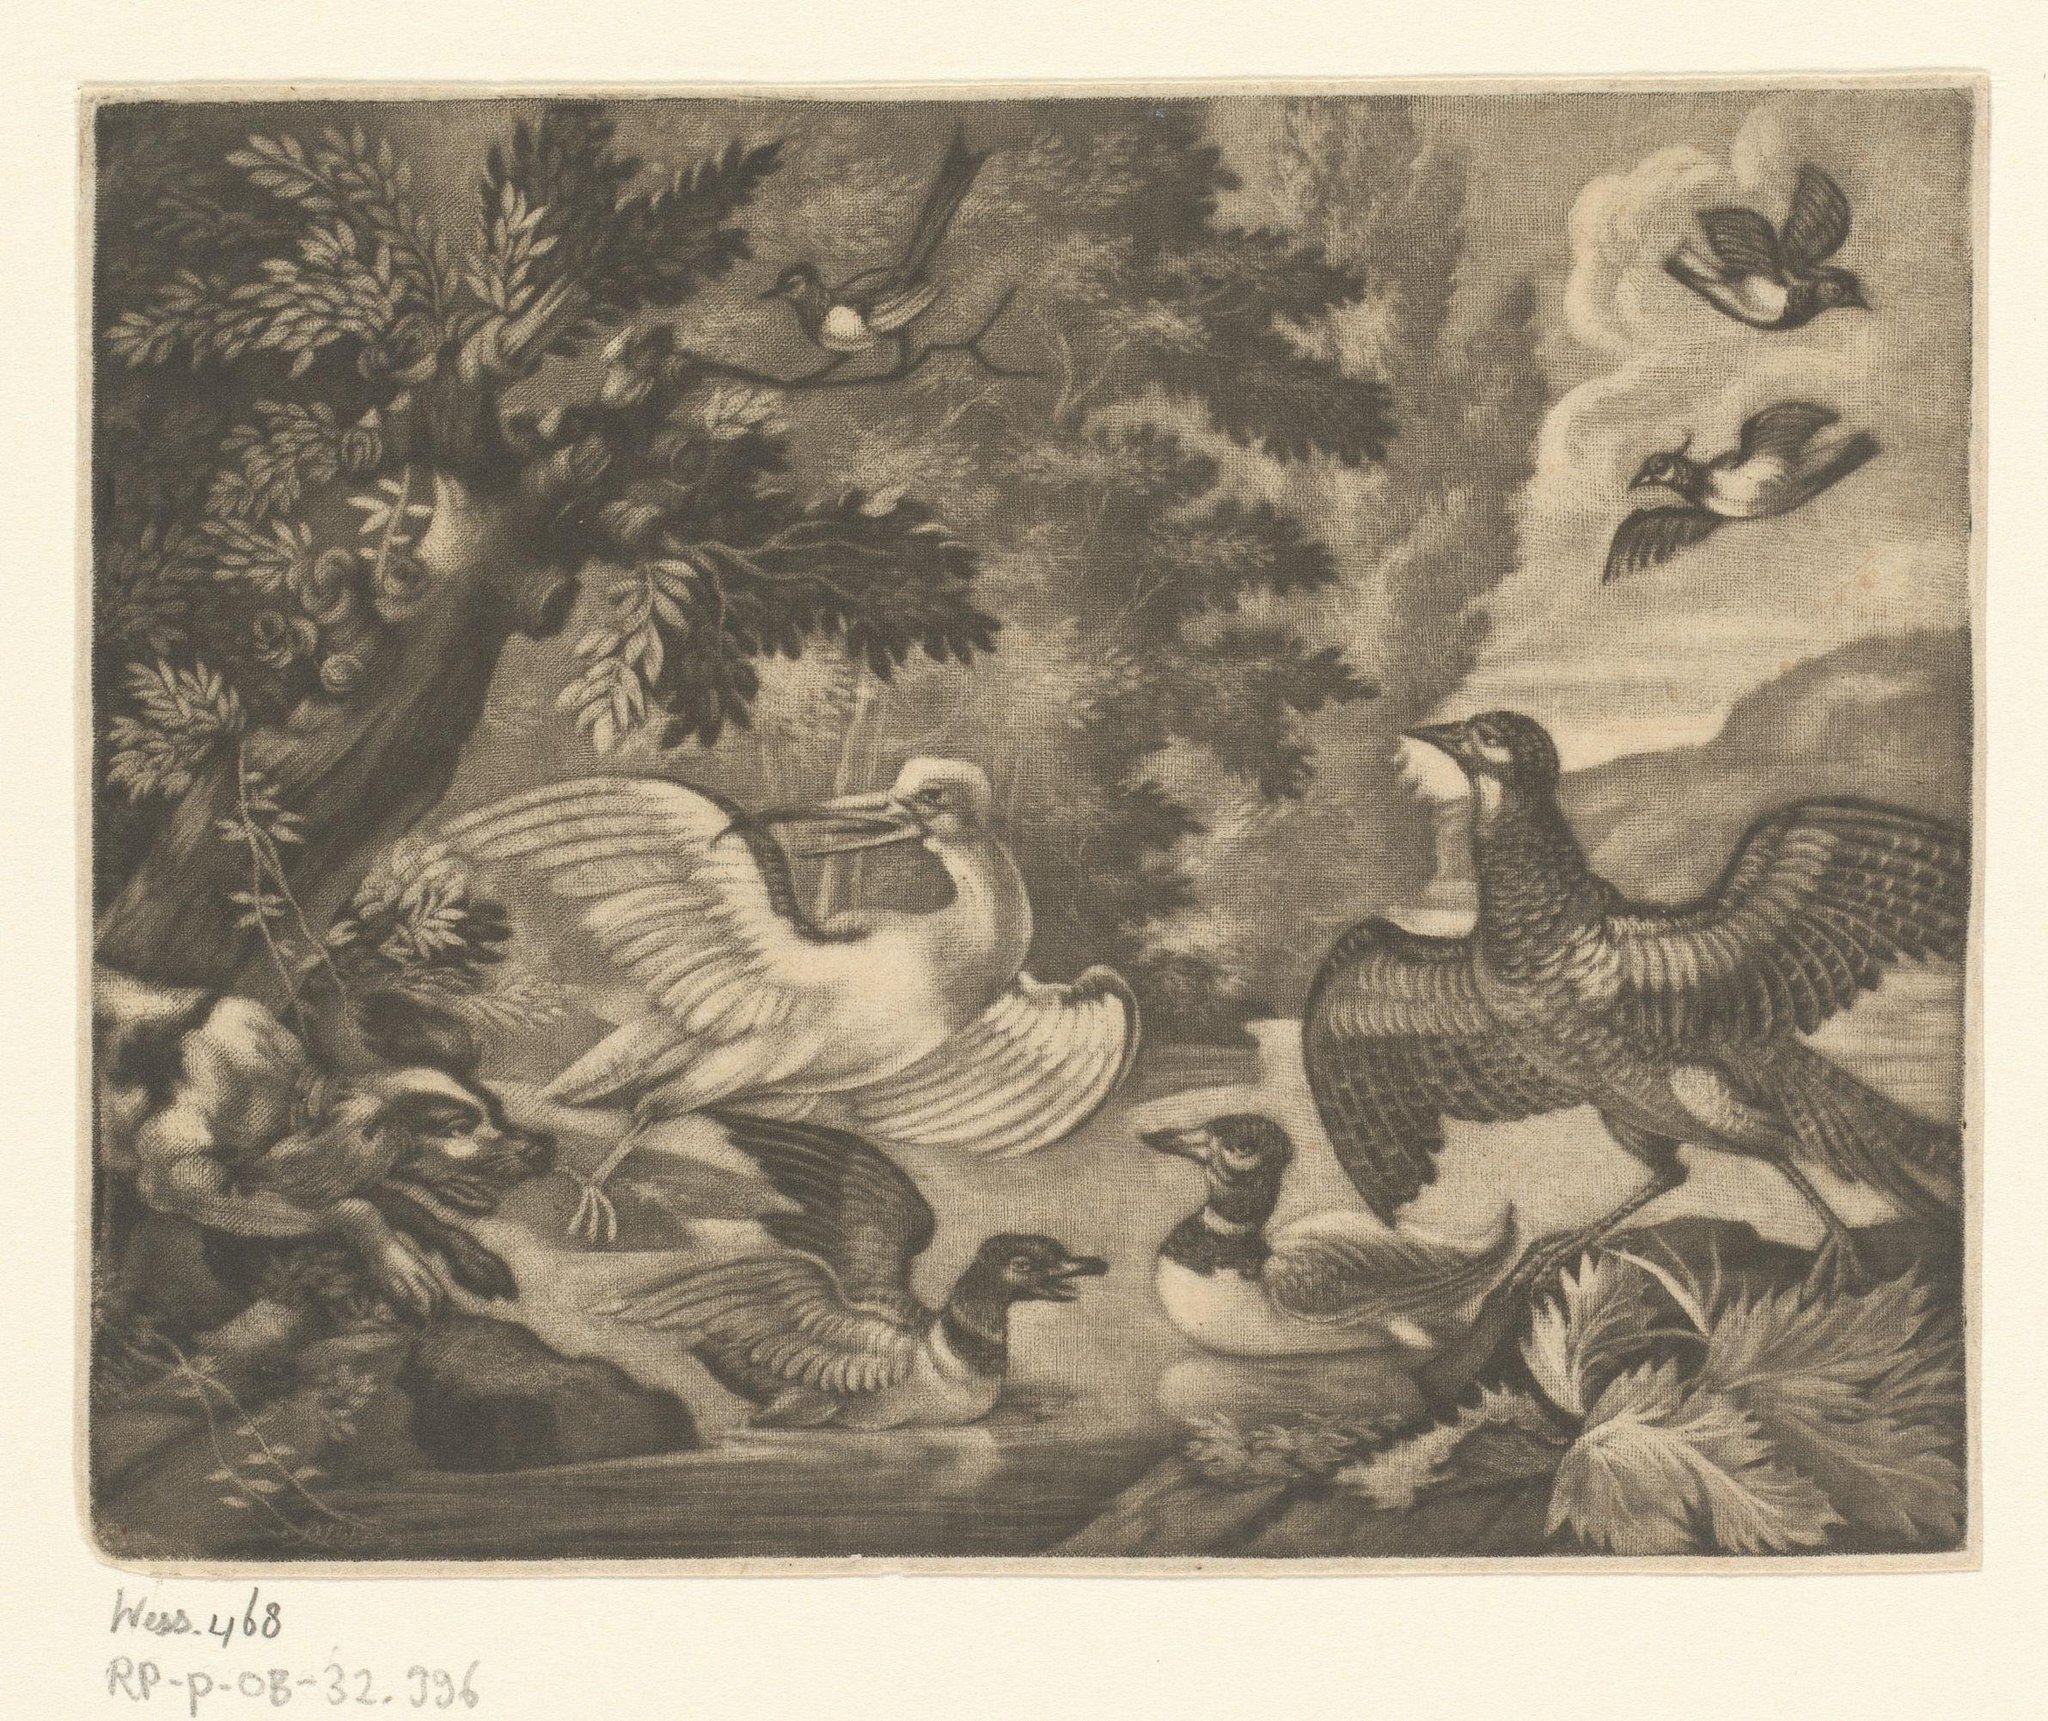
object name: print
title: Watervogels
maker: john smith (prentmaker/ uitgever)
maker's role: print maker, publisher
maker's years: 1652-1743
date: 1662-1742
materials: paper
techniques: mezzotint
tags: water-birds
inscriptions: collector's mark: Lugt 240